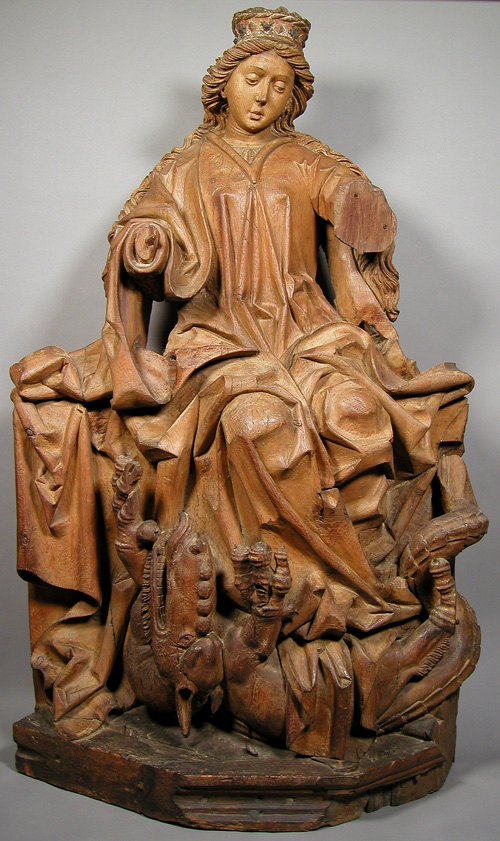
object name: statue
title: Saint Margaret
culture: austrian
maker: michael pacher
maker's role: artist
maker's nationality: austrian or german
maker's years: 1430-1498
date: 1470-1480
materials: gesso, metal, paint, wood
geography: trentino-alto adige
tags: women,dragons,saints